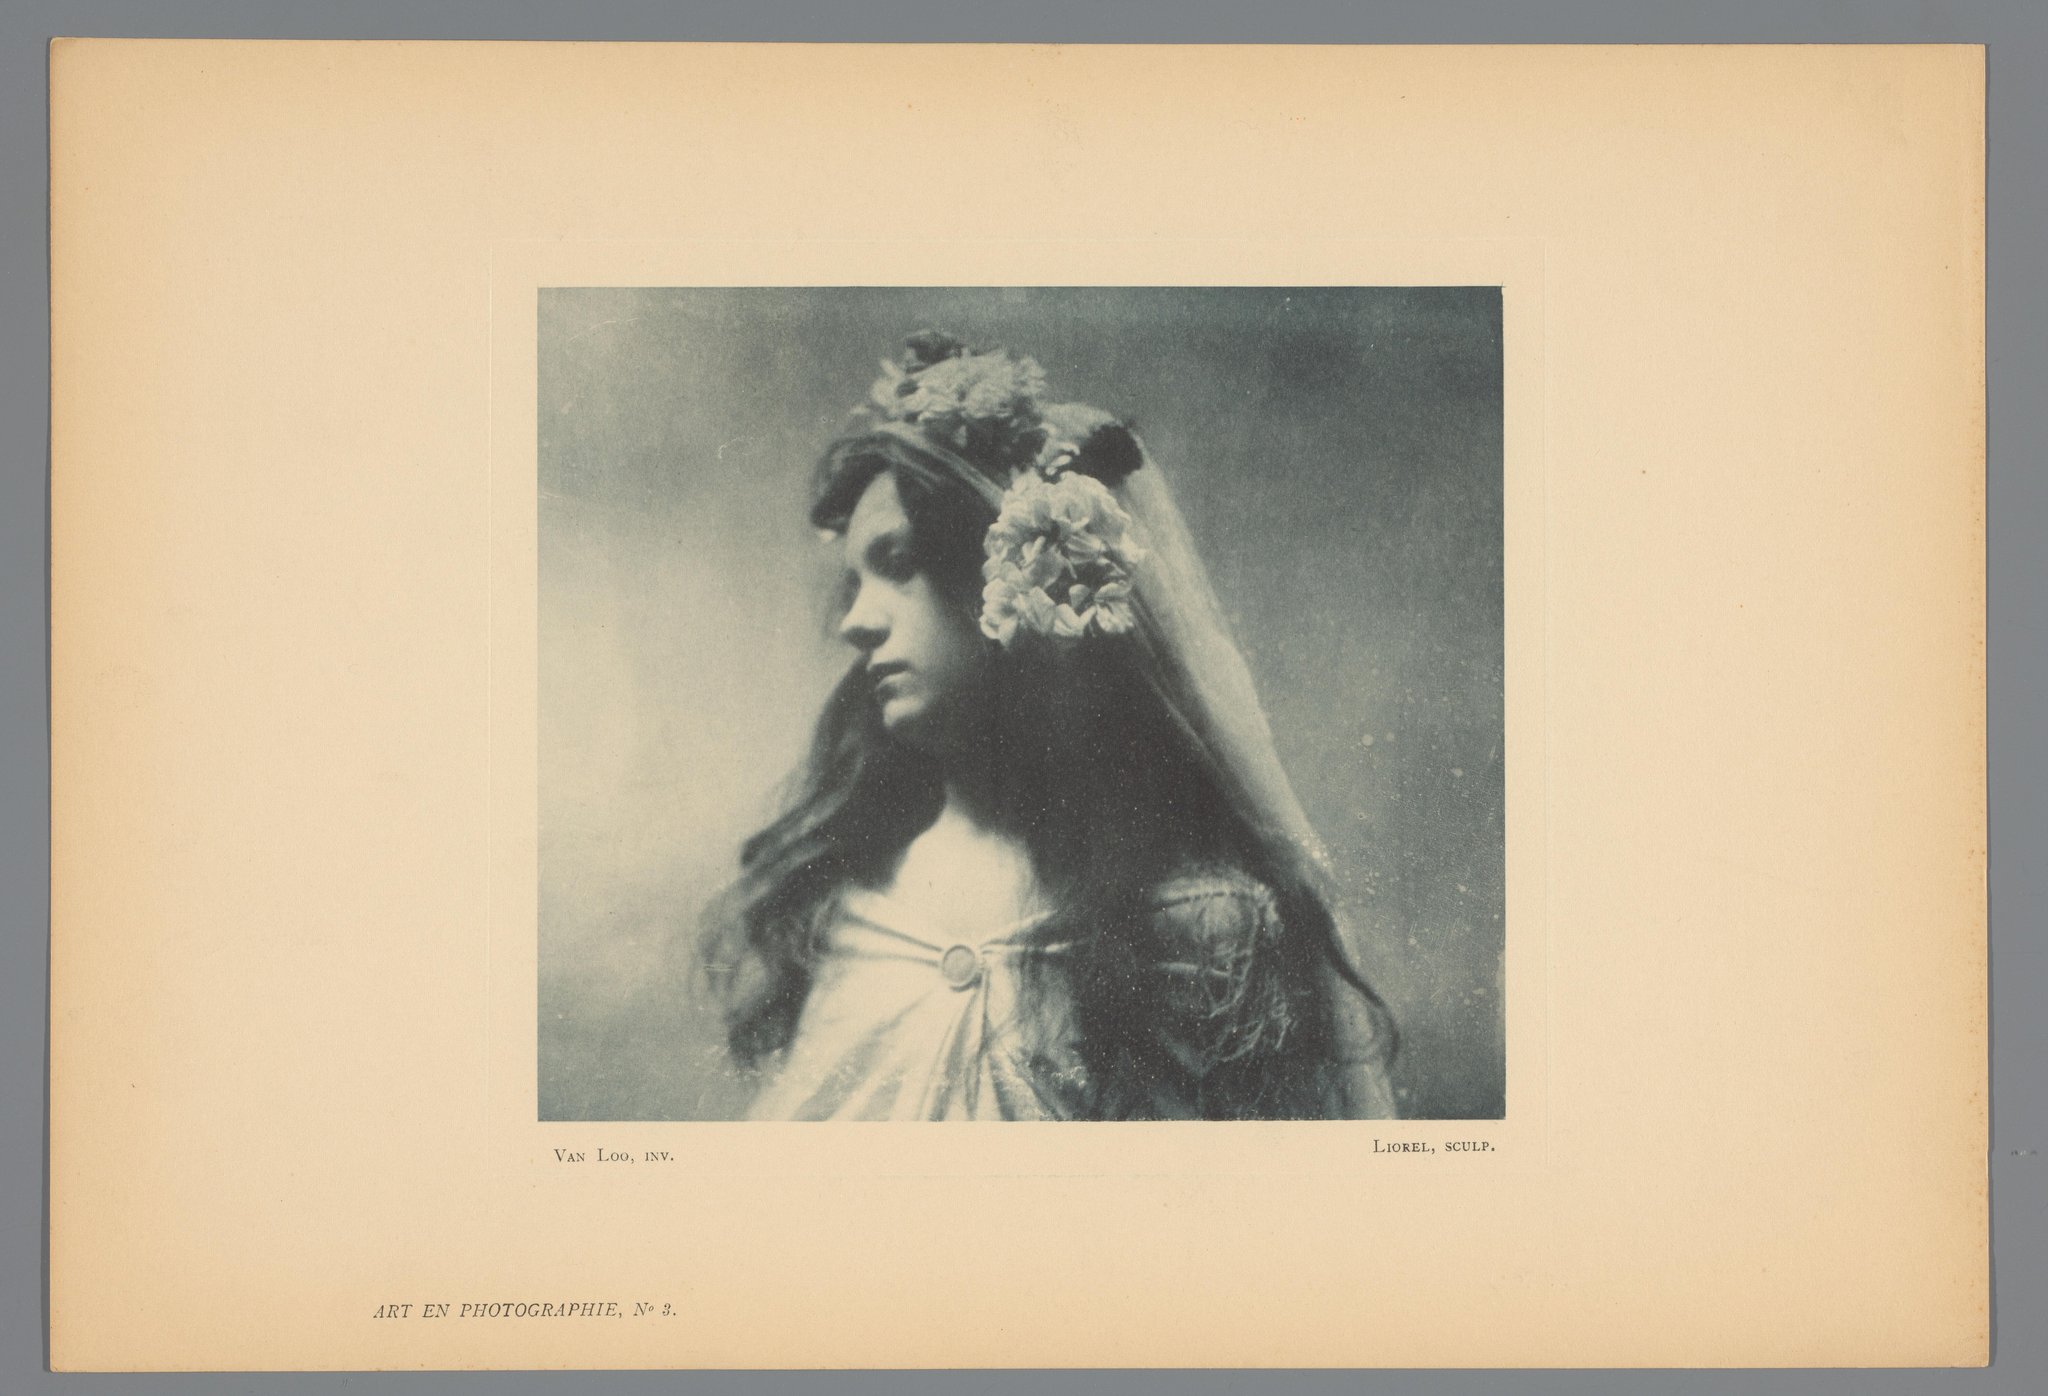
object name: photomechanical print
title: Portret van een onbekende vrouw met een bloemenkrans op haar hoofd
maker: Anonymous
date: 1896-1901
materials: paper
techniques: photograph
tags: garland, wreath, historical persons - bb - woman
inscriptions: name: ‘Van Loo, inv.’, inscription: ‘ART EN PHOTOGRAPHIE, No 3.’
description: Deze prent maakt deel uit van een omslag met 54 prenten op 52 bladen.